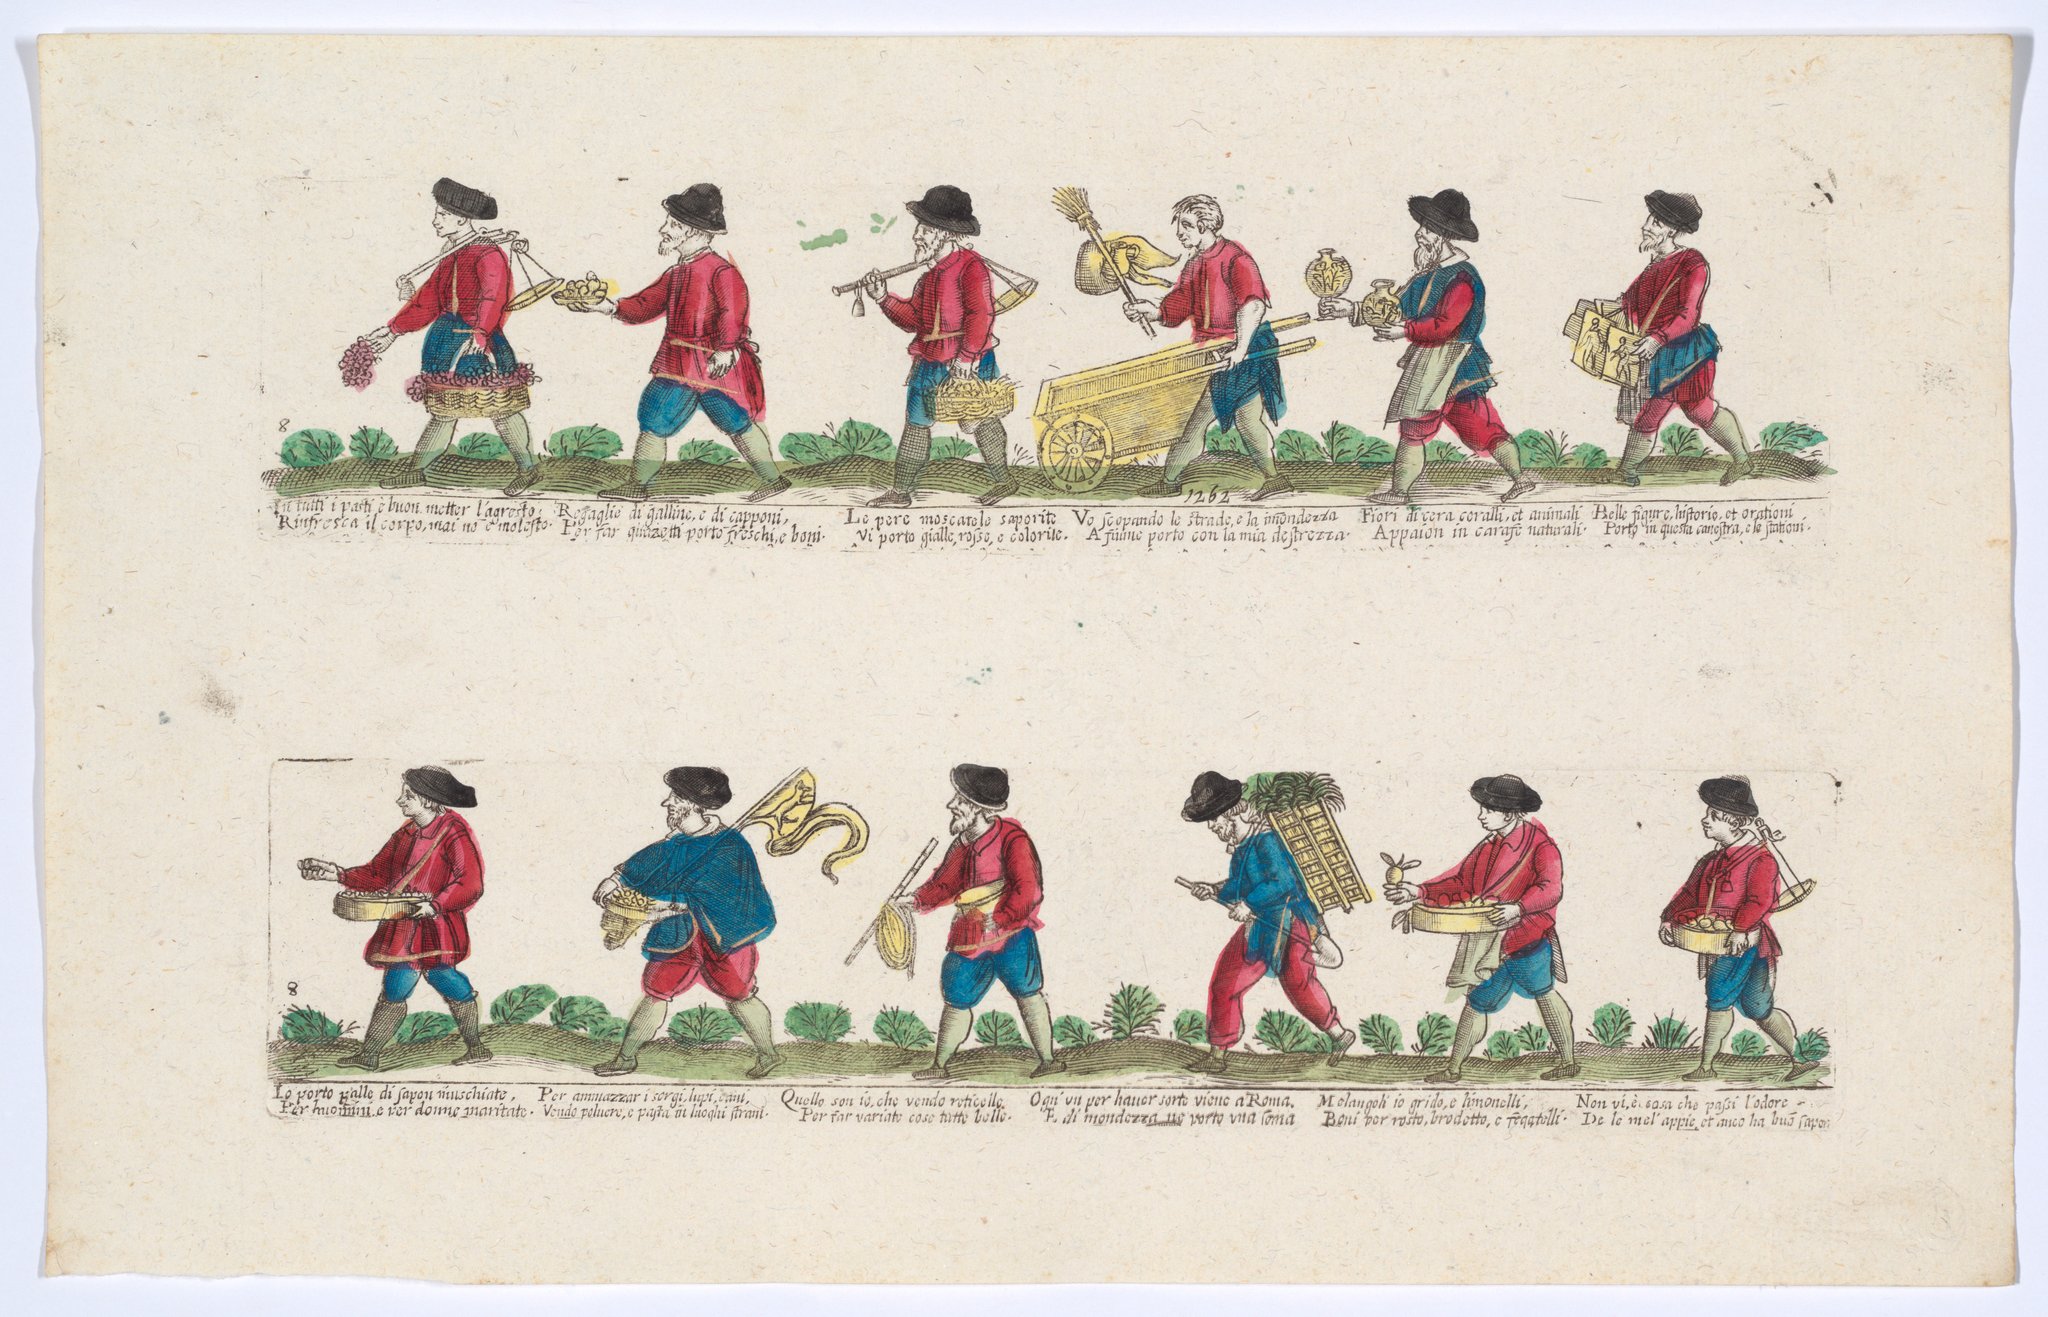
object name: print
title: Plate 8 depicting the trades of Rome,here including vendors of coral, images, lemons etc., from the "Descrición de las artes que se llaman para los calles de la ciudad de Roma"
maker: remondini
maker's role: publisher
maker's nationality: italian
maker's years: 1650-1860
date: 1770-1800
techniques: engraving, hand coloring